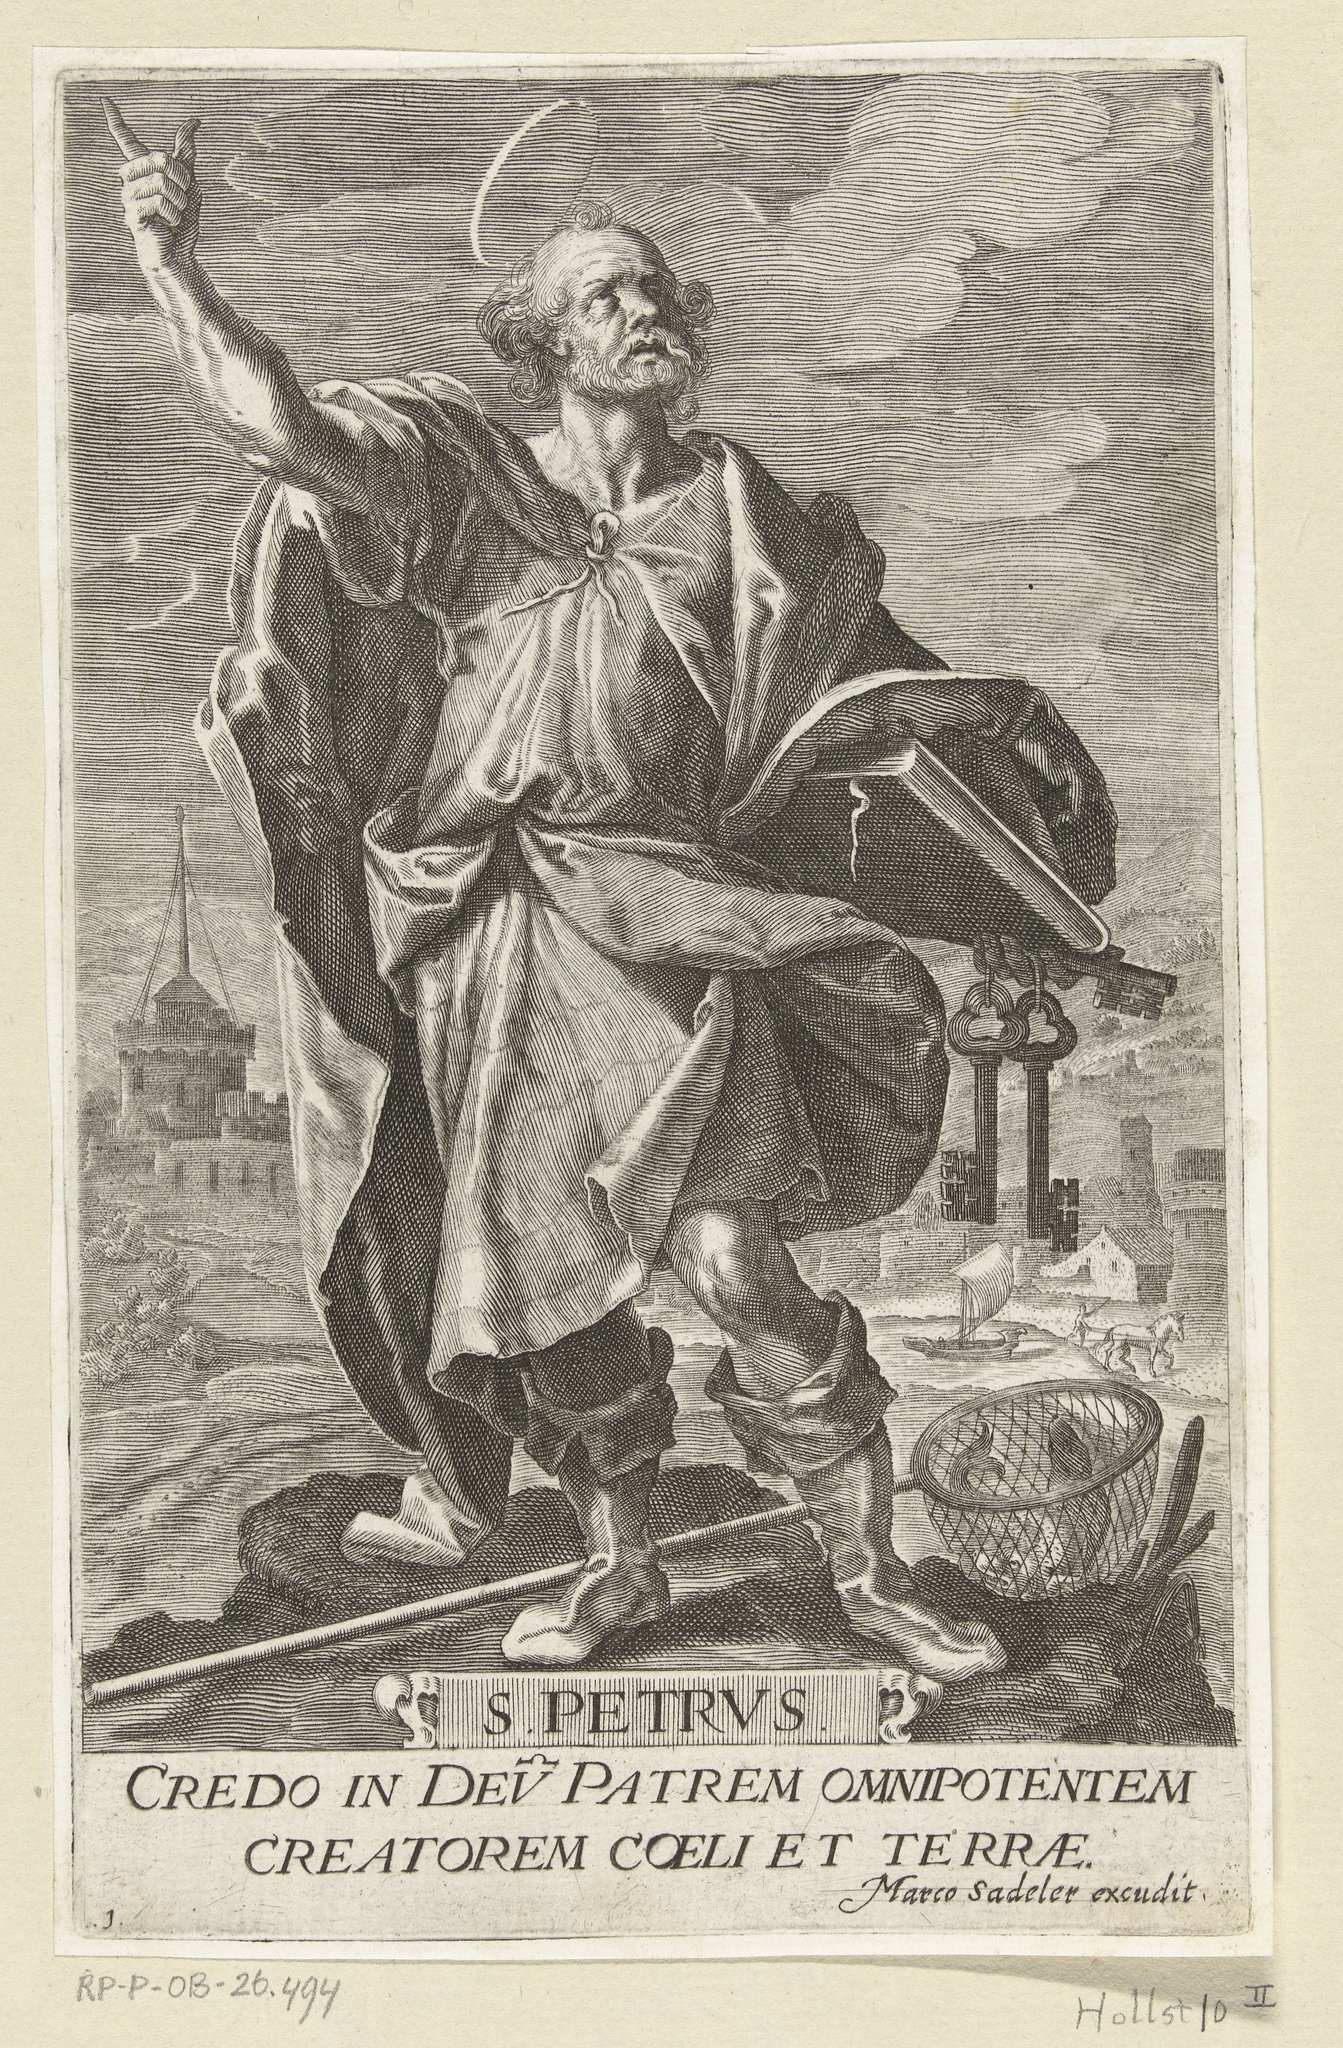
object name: print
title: Apostel Petrus met sleutels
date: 1591-1629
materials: paper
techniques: engraving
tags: the apostle peter, first bishop of rome; possible attributes: book, cock, (upturned) cross, (triple) crozier, fish, key, scroll, ship, tiara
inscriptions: collector's mark: Lugt 240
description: Apostel Petrus met sleutels en visnet. Op de achtergrond de stad Rome met de Engelenburcht. Onder de voorstelling staat een Latijnse regel uit de apostolische geloofsbelijdenis.